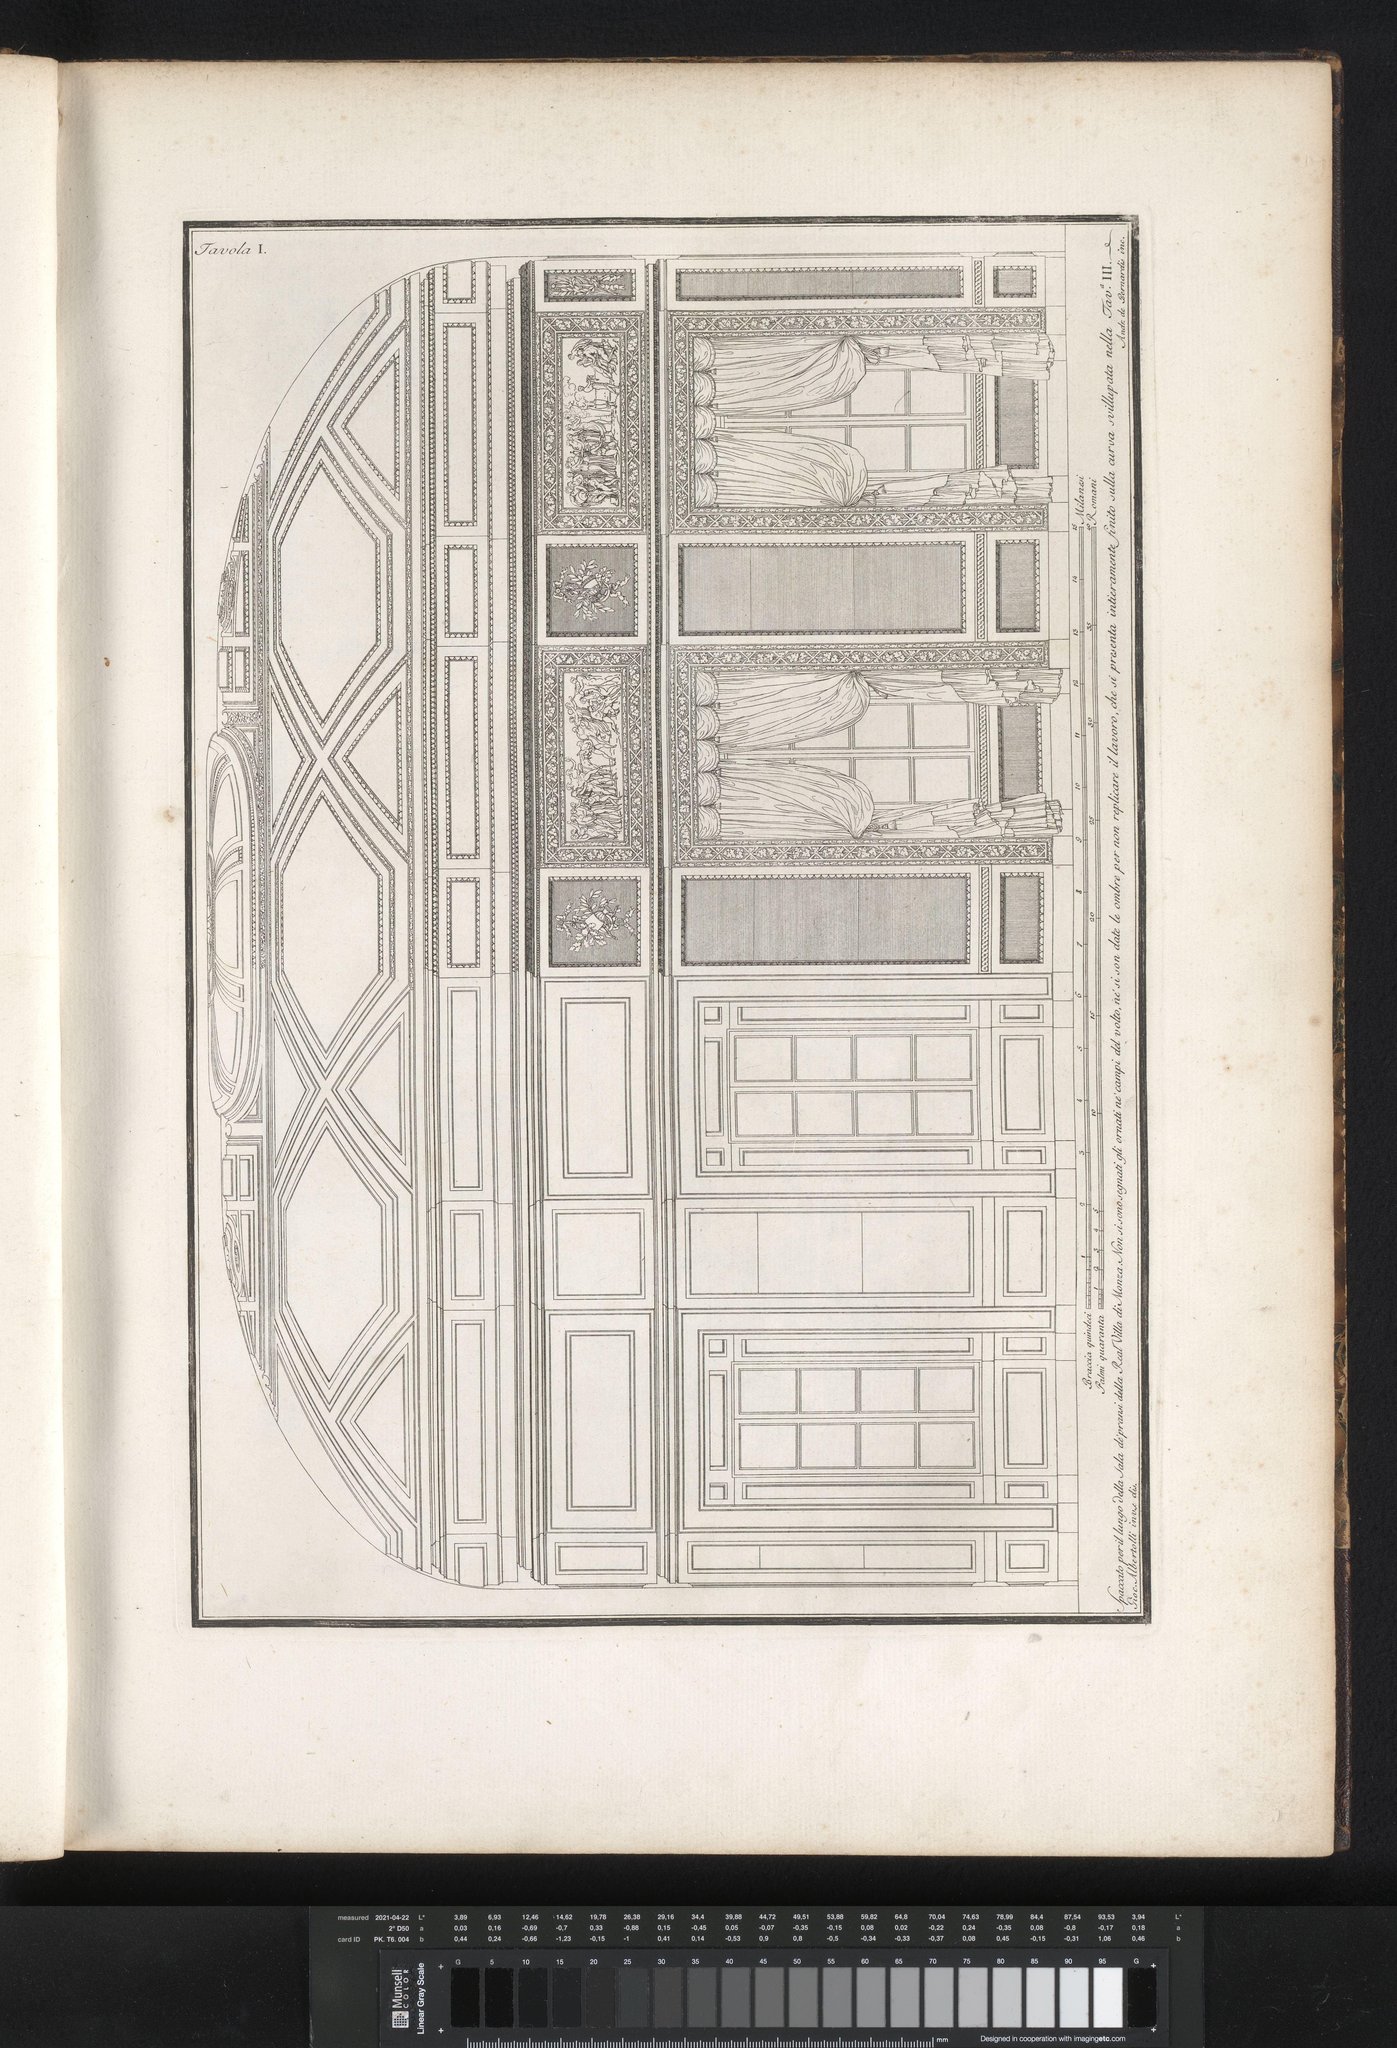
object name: ornament print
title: Alcune Decorazioni di Nobili Sale ed Altri Ornamenti di Giocondo Albertolli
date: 1787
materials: paper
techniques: engraving, etching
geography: milan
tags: decorative furniture, ornaments ~ art, window, door, wall-covering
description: Wand met twee deuren en twee ramen met gordijnen. Voor een zaal in de Villa Reale in Monza. Tavola I. Onderdeel van het album met twee series ornamentprenten naar Giocondo Albertolli.